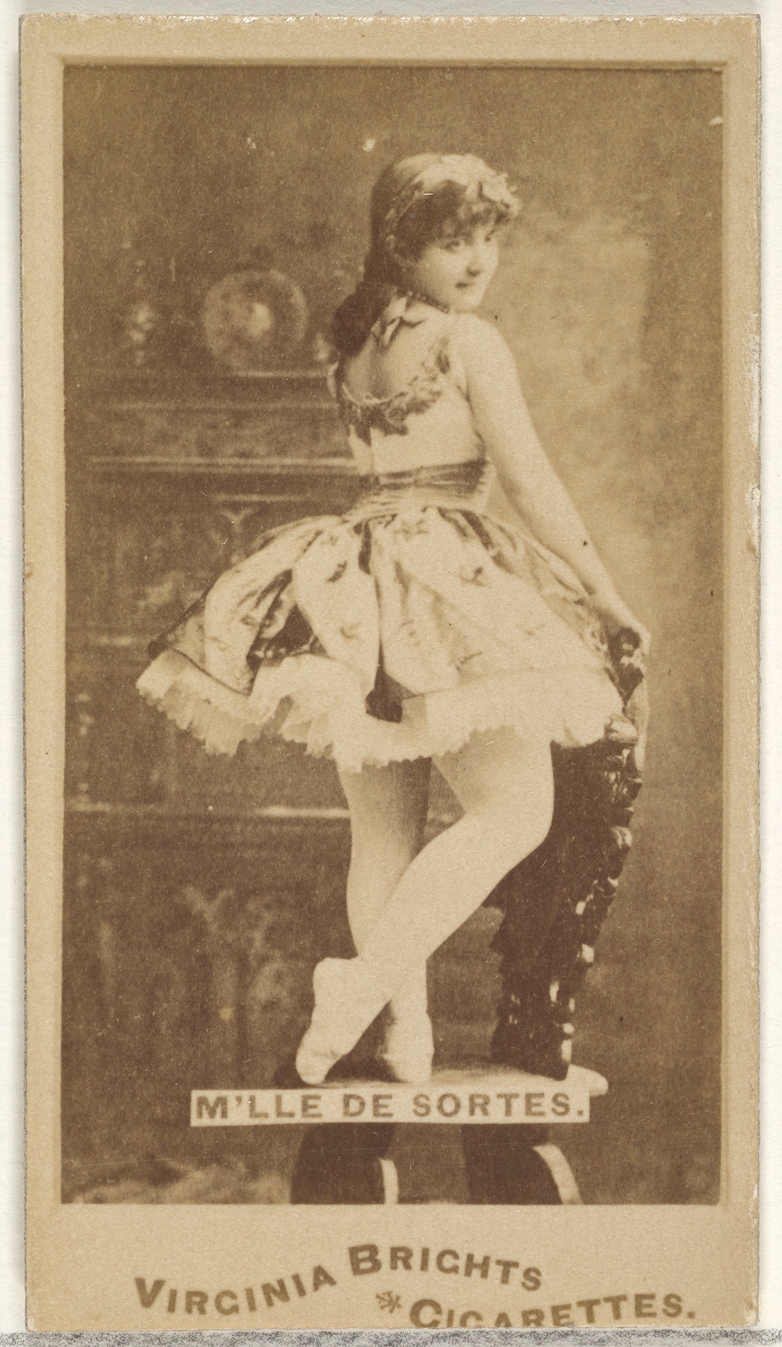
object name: photograph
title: Mlle. de Sortes, from the Actors and Actresses series (N45, Type 1) for Virginia Brights Cigarettes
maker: allen & ginter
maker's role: publisher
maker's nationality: american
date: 1888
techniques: albumen silver print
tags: portraits,women,actresses